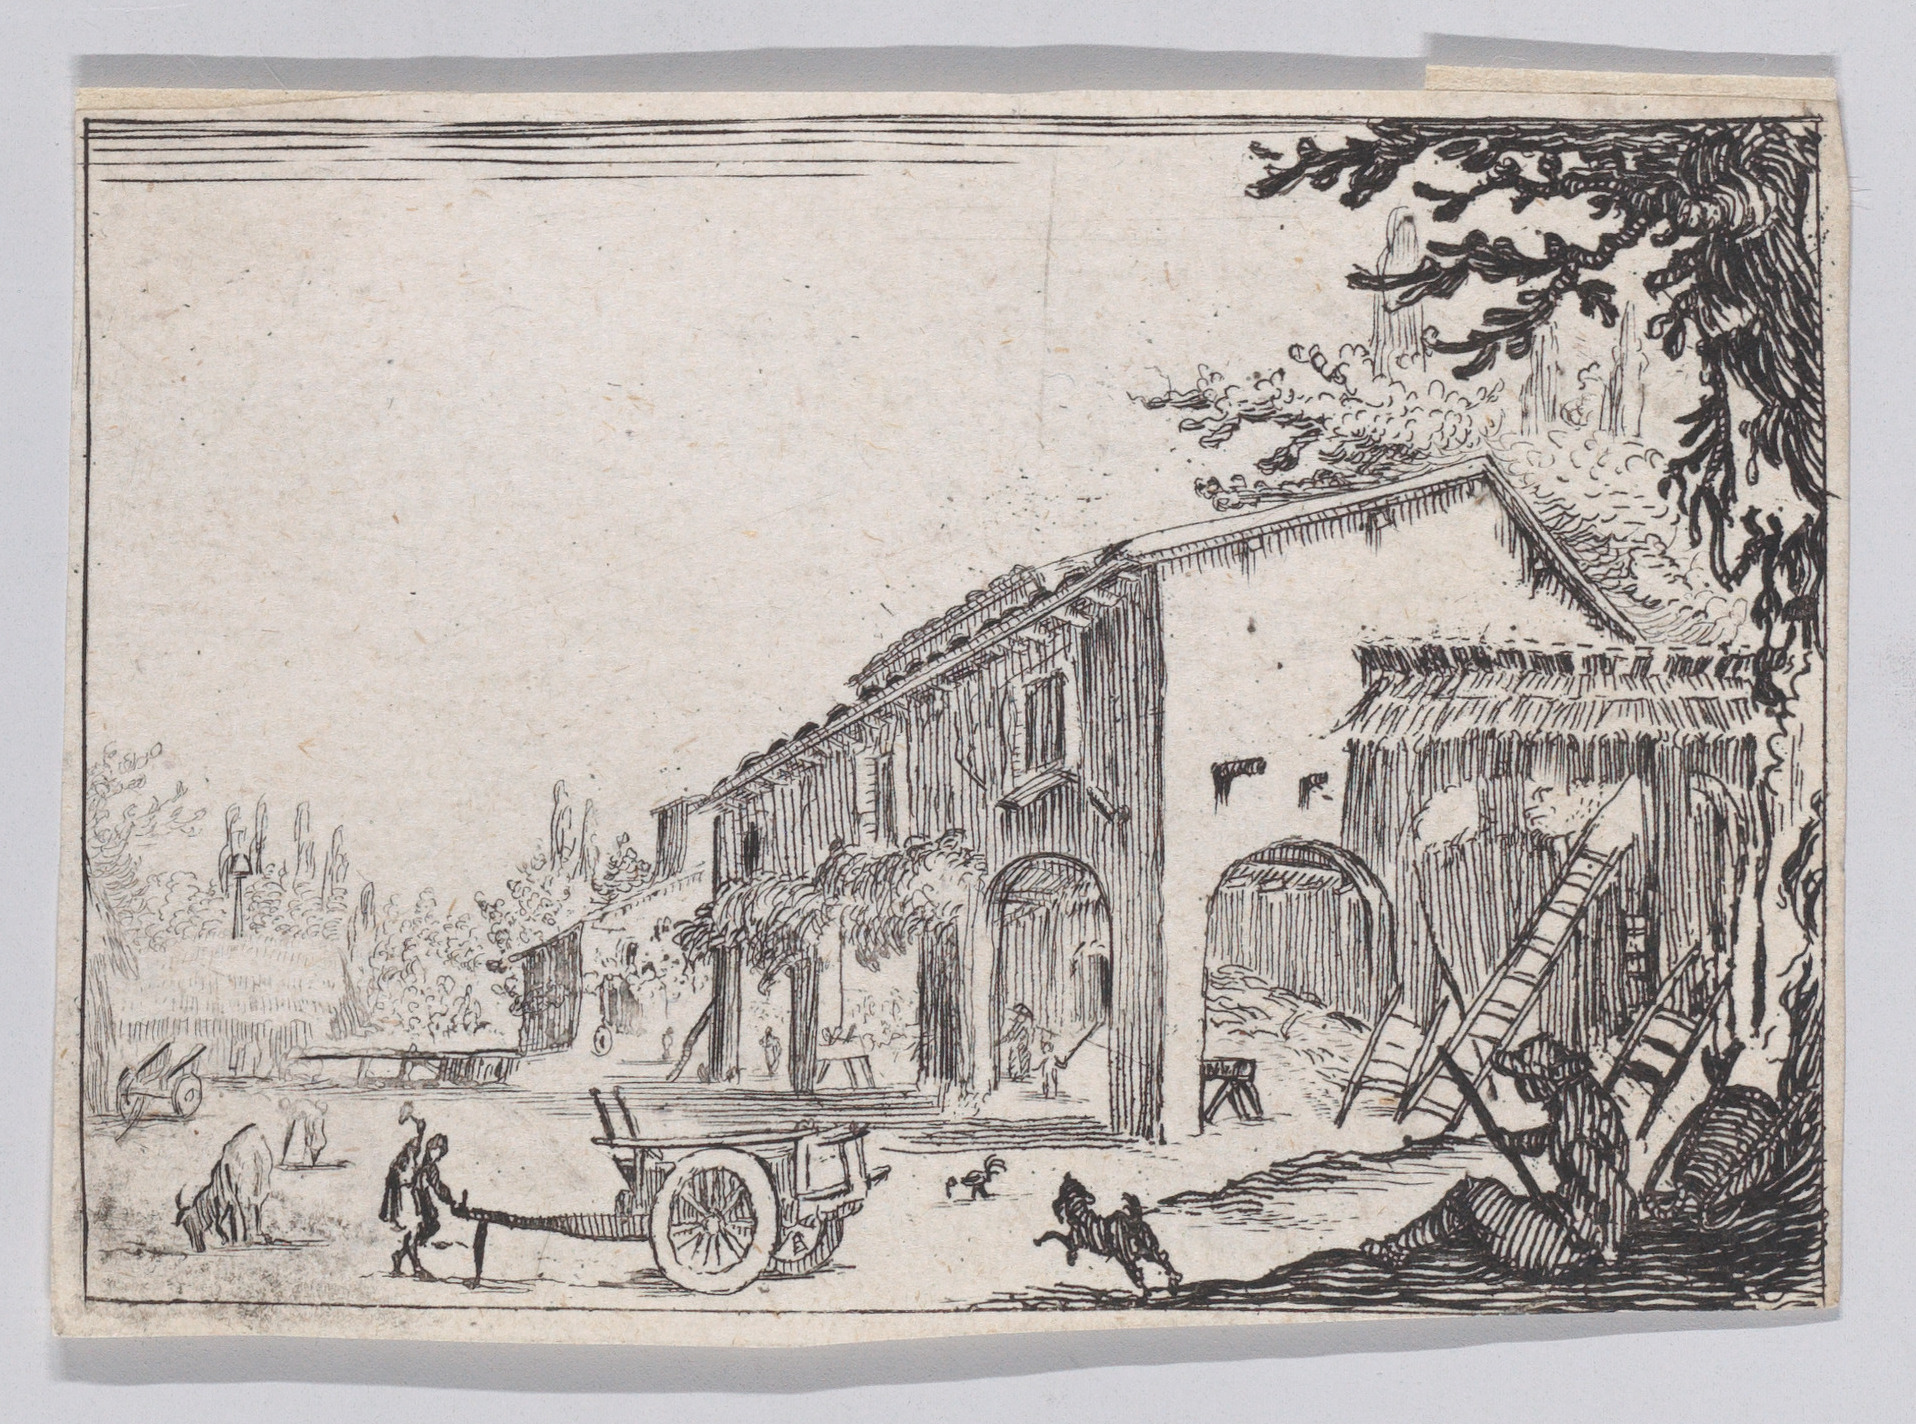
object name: print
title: Reverse Copy of La Factoria (The Factory), from "Les Caprices"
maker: Anonymous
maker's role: artist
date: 1601-1700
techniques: etching